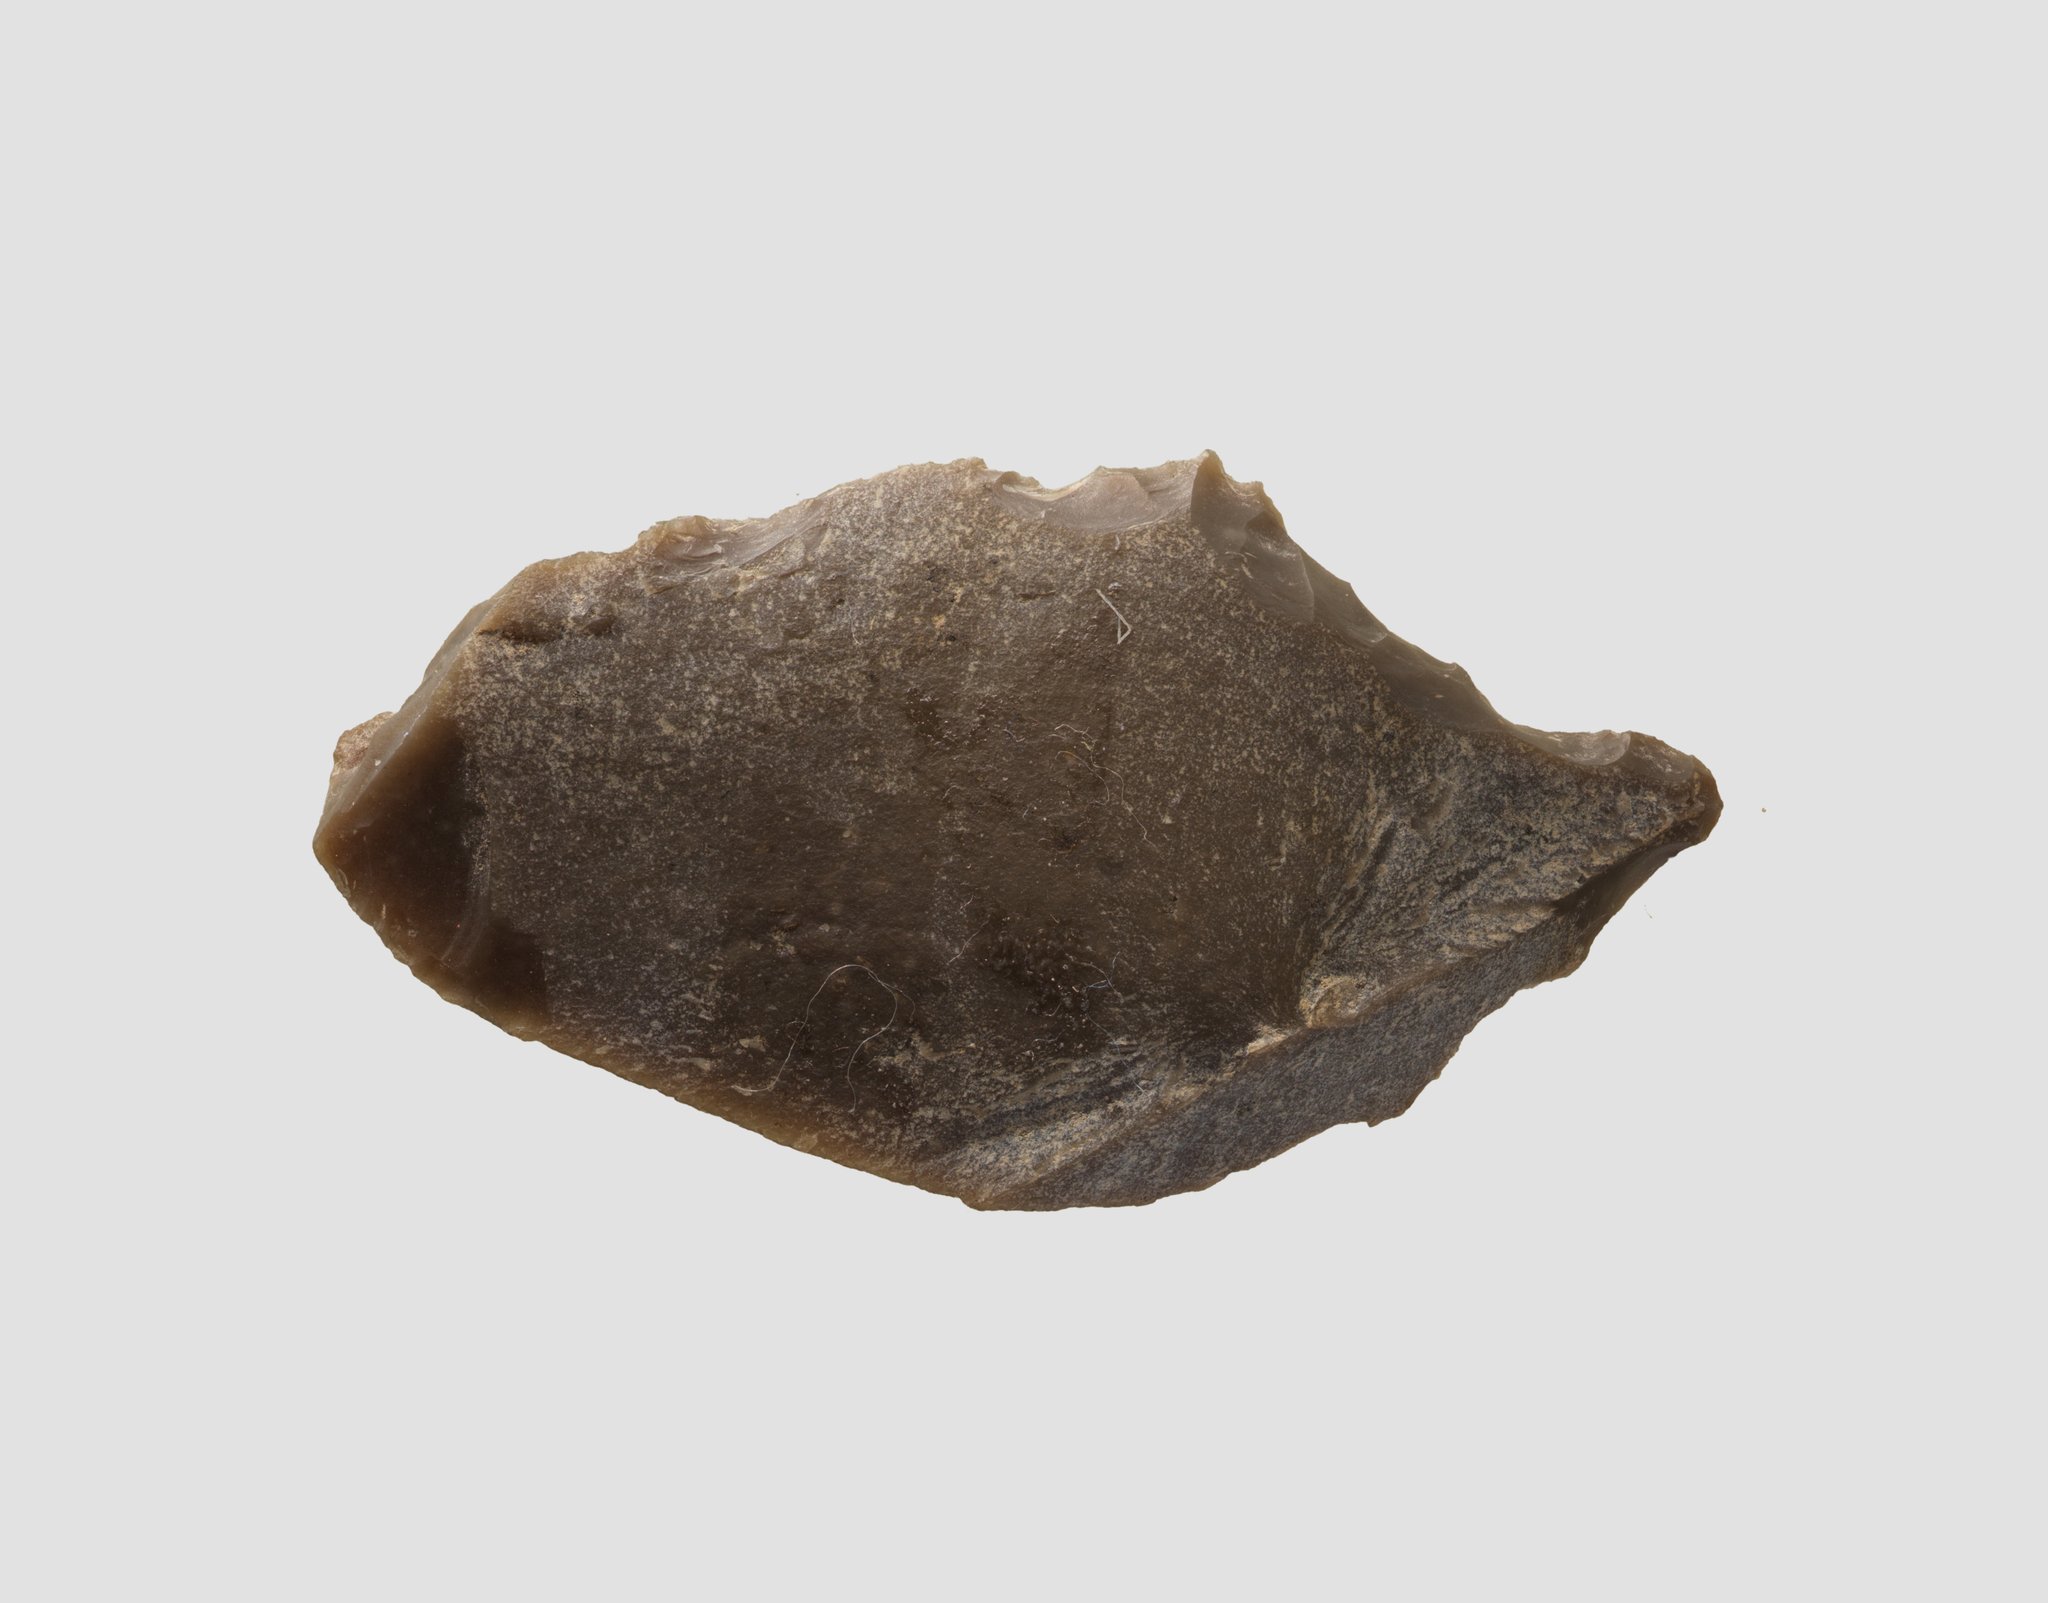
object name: awl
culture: ghassulian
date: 4600-3600 BCE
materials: stone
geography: levant